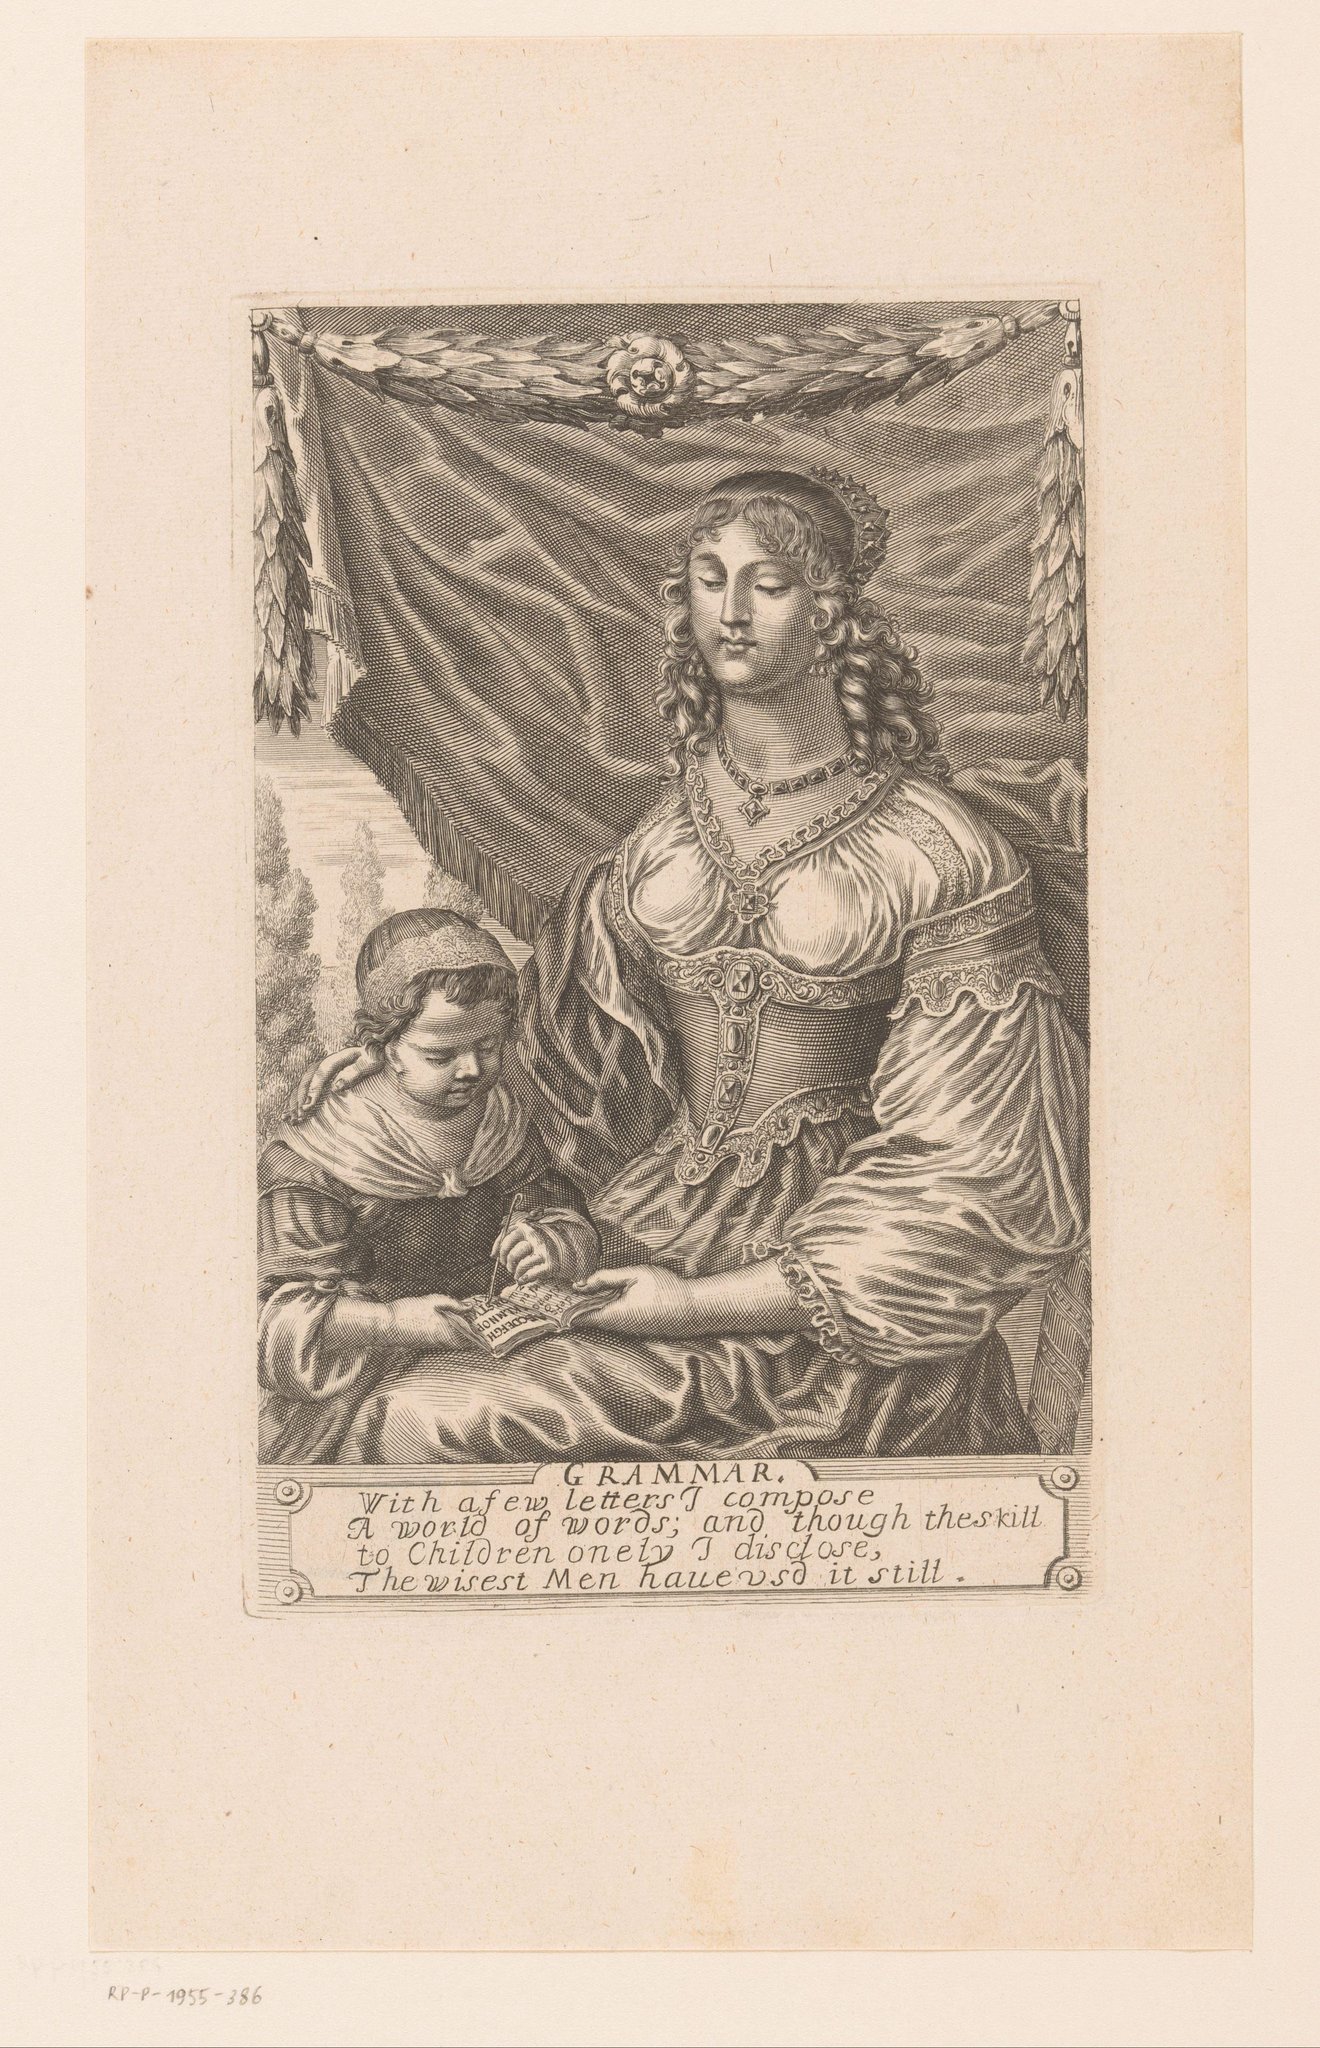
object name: print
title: Minerva en de zeven vrije kunsten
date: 1623-1681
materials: paper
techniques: engraving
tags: 'grammatica' (~ trivium); 'grammatica' (ripa)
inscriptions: collector's mark: Lugt 2228, collector's mark: Lugt 847a, collector's mark: Lugt 919ter